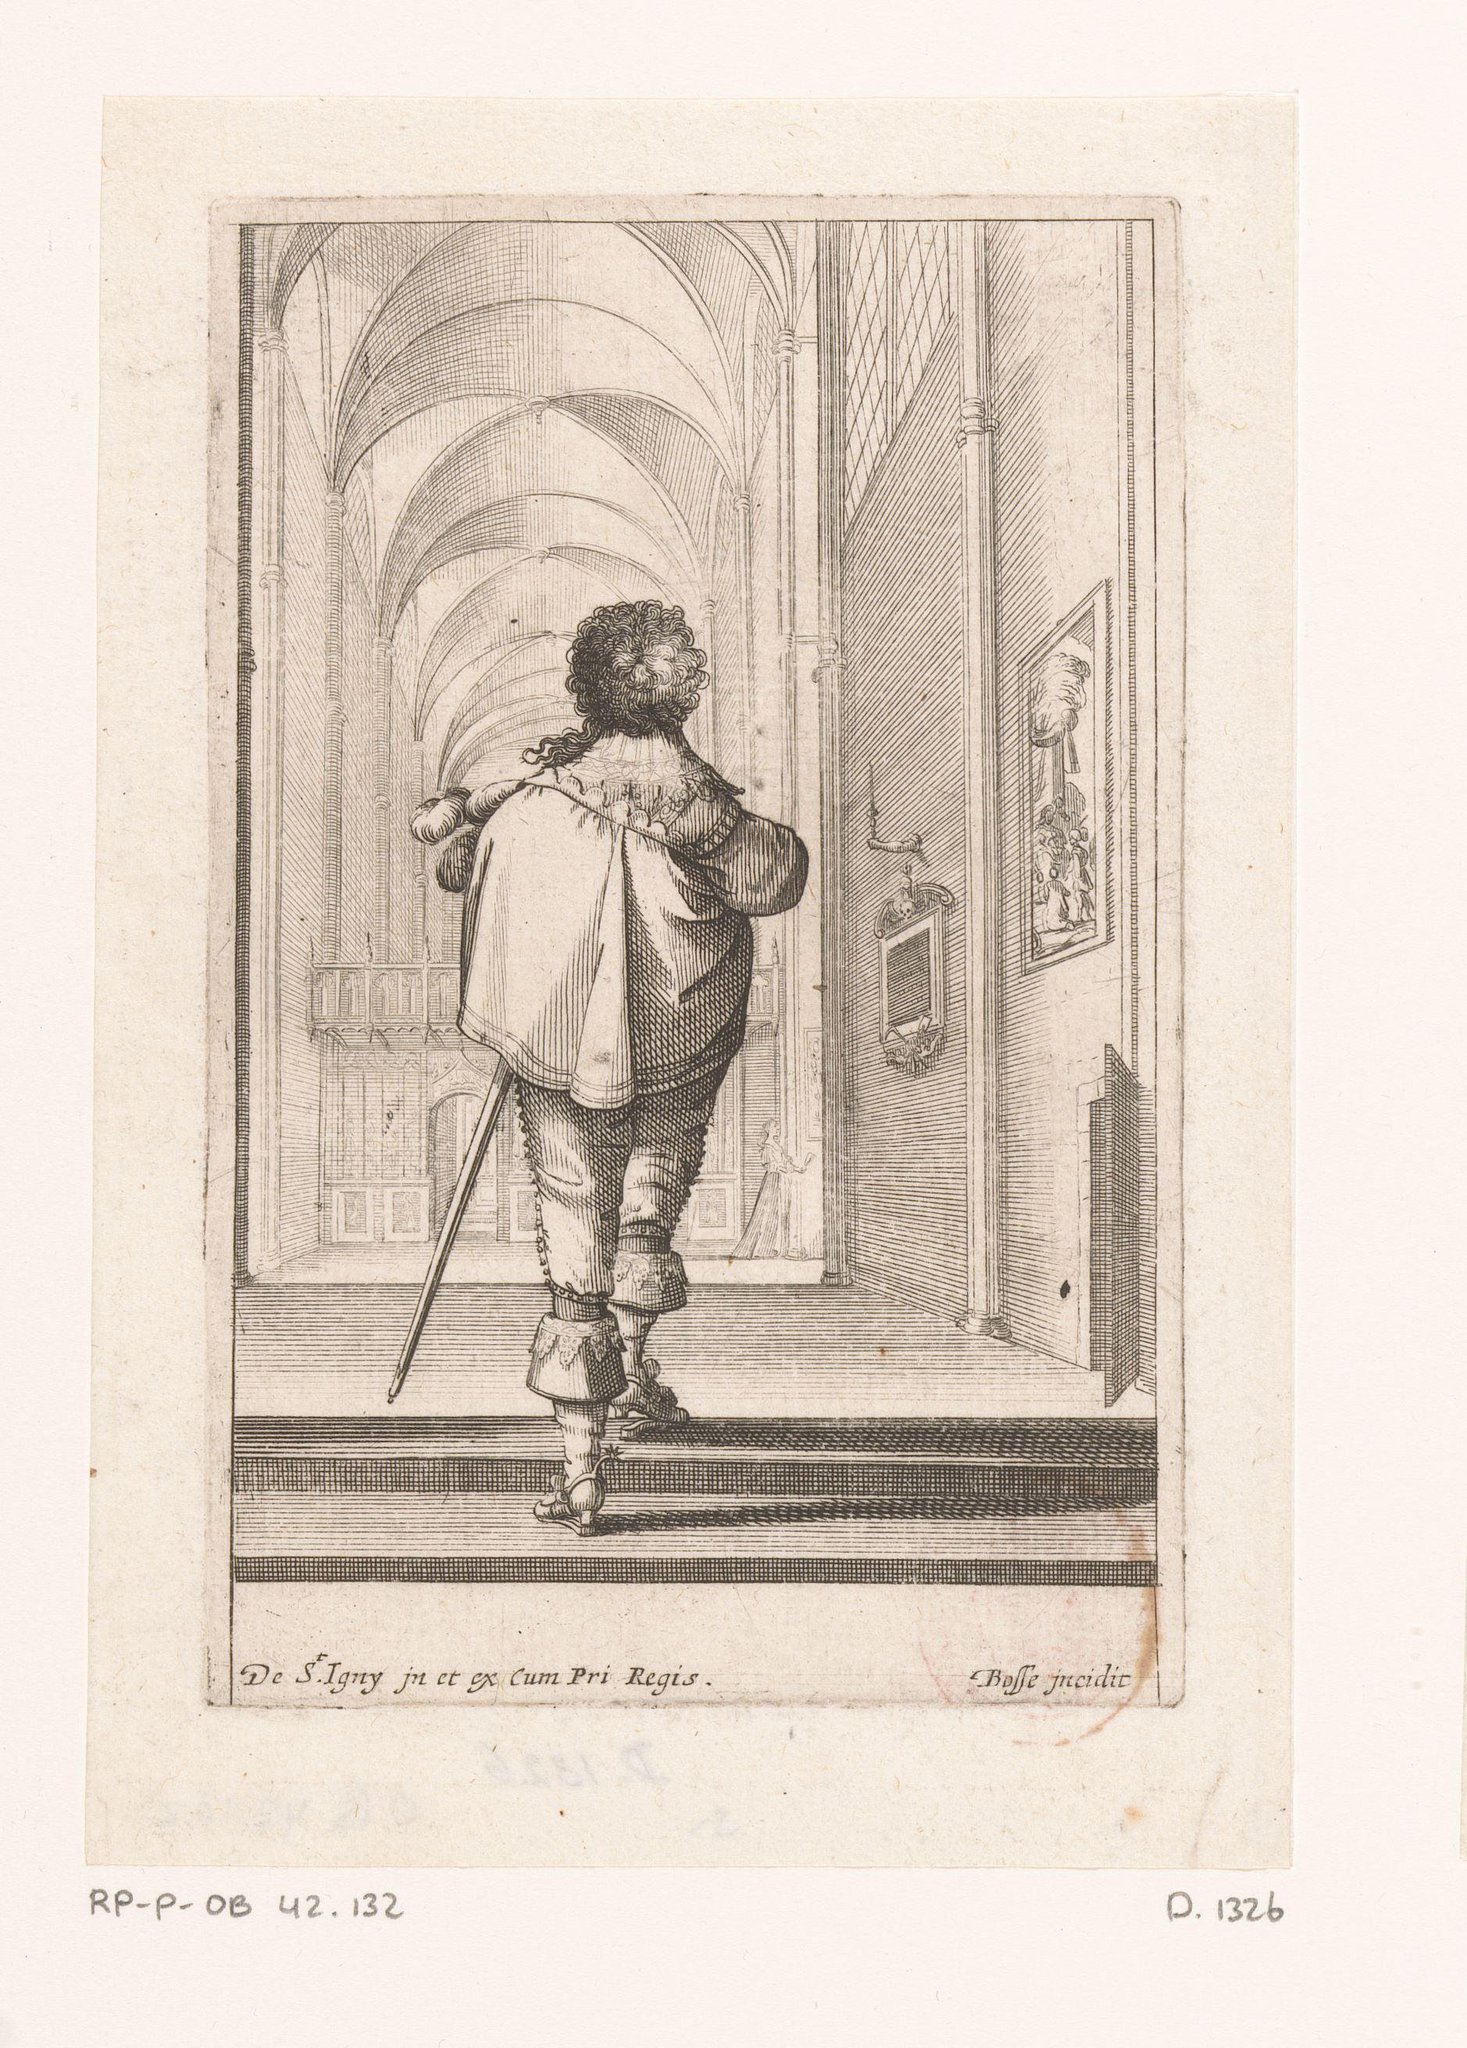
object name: costume print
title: La Noblesse Française à l’église (The French Nobility at Church)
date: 1628-1629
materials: paper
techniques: engraving, etching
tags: cape (+ men's clothes), head-gear: hat (+ men's clothes), styles of hairdress, europeans (with name), interior of church, clothes, costume (+ men's clothes), neck-gear: collar (+ men's clothes), trousers, breeches, etc. (breeches) (+ men's clothes), hacking and thrusting weapons (foil), boots (+ men's clothes)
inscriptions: collector's mark: Lugt 240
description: Bosse portrayed the Gothic churches of Paris as sites of piety and fashionability. While praying or merely strutting through the centuries-old architecture, the churchgoers in these prints sport the latest styles. For example, in the few years since Callot’s series (adjacent), an ornate and expensive form of lace cutwork – reticella – had become a popular form of decoration for collars and cuffs.